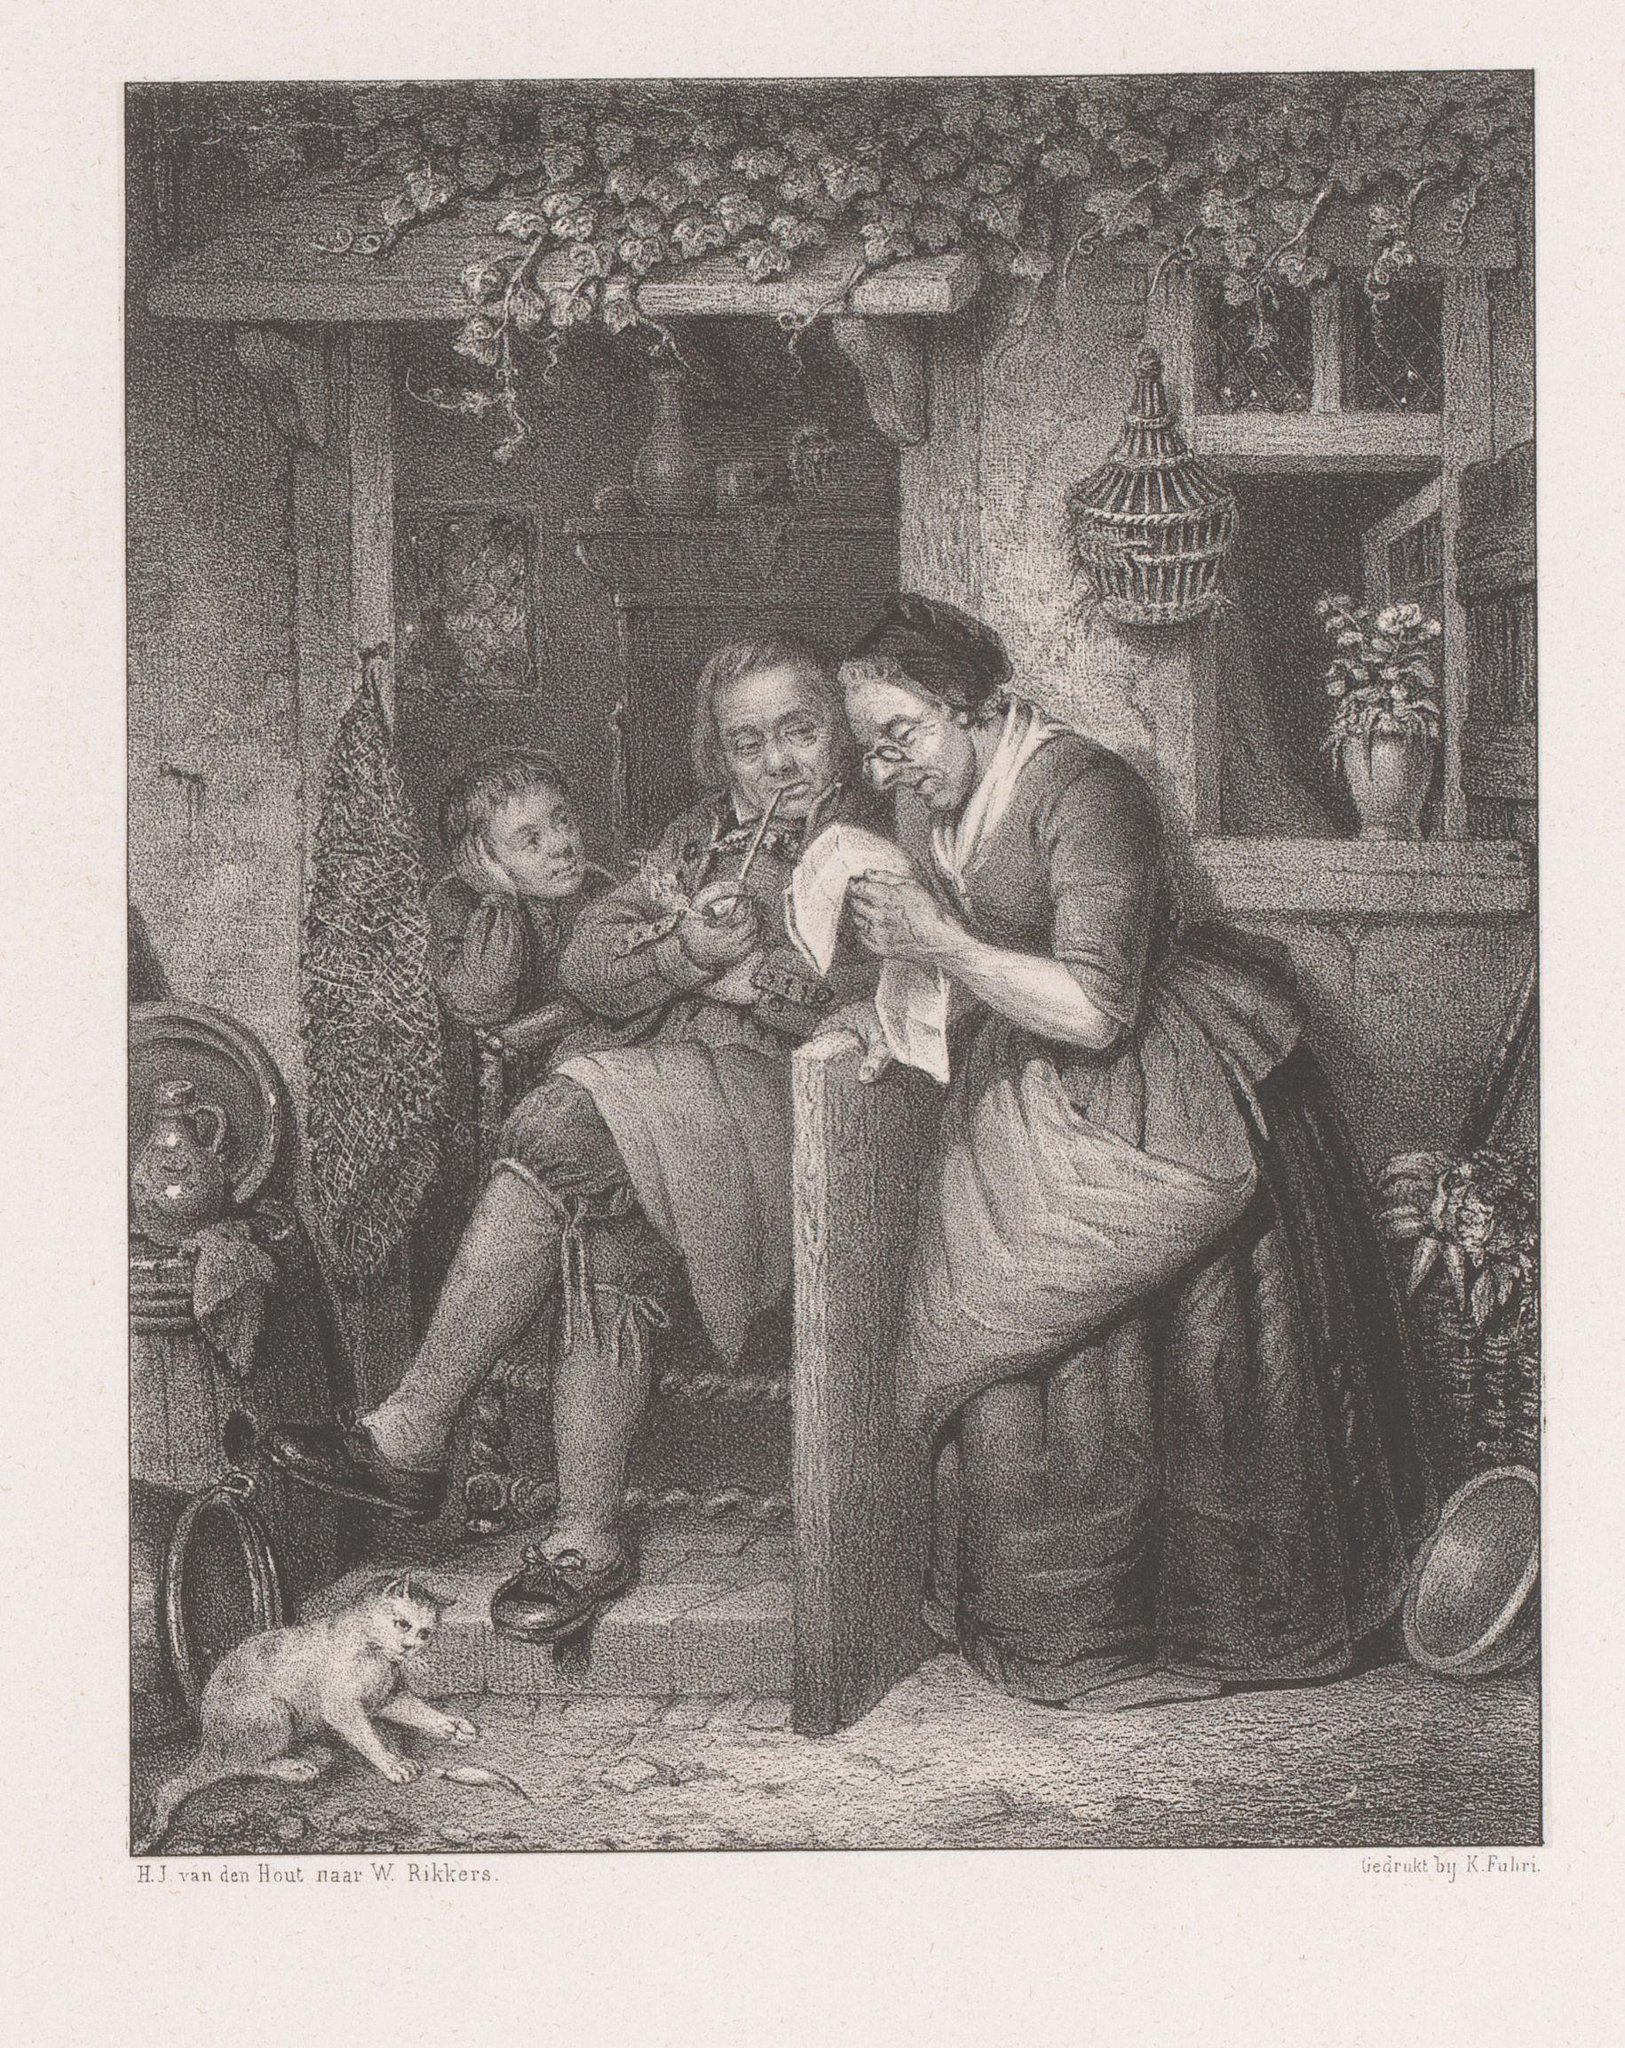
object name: print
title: Brieflezende vrouw met man en kind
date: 1837-1853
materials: paper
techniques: lithograph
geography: the hague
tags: pipe ~ tobacco, reading to somebody, front steps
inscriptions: collector's mark: Lugt 2228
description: Het gezelschap zit in de deuropening van een huis. De man rookt een pijp, de jongen zit naast hem. De vrouw draagt een bril en leest een brief.